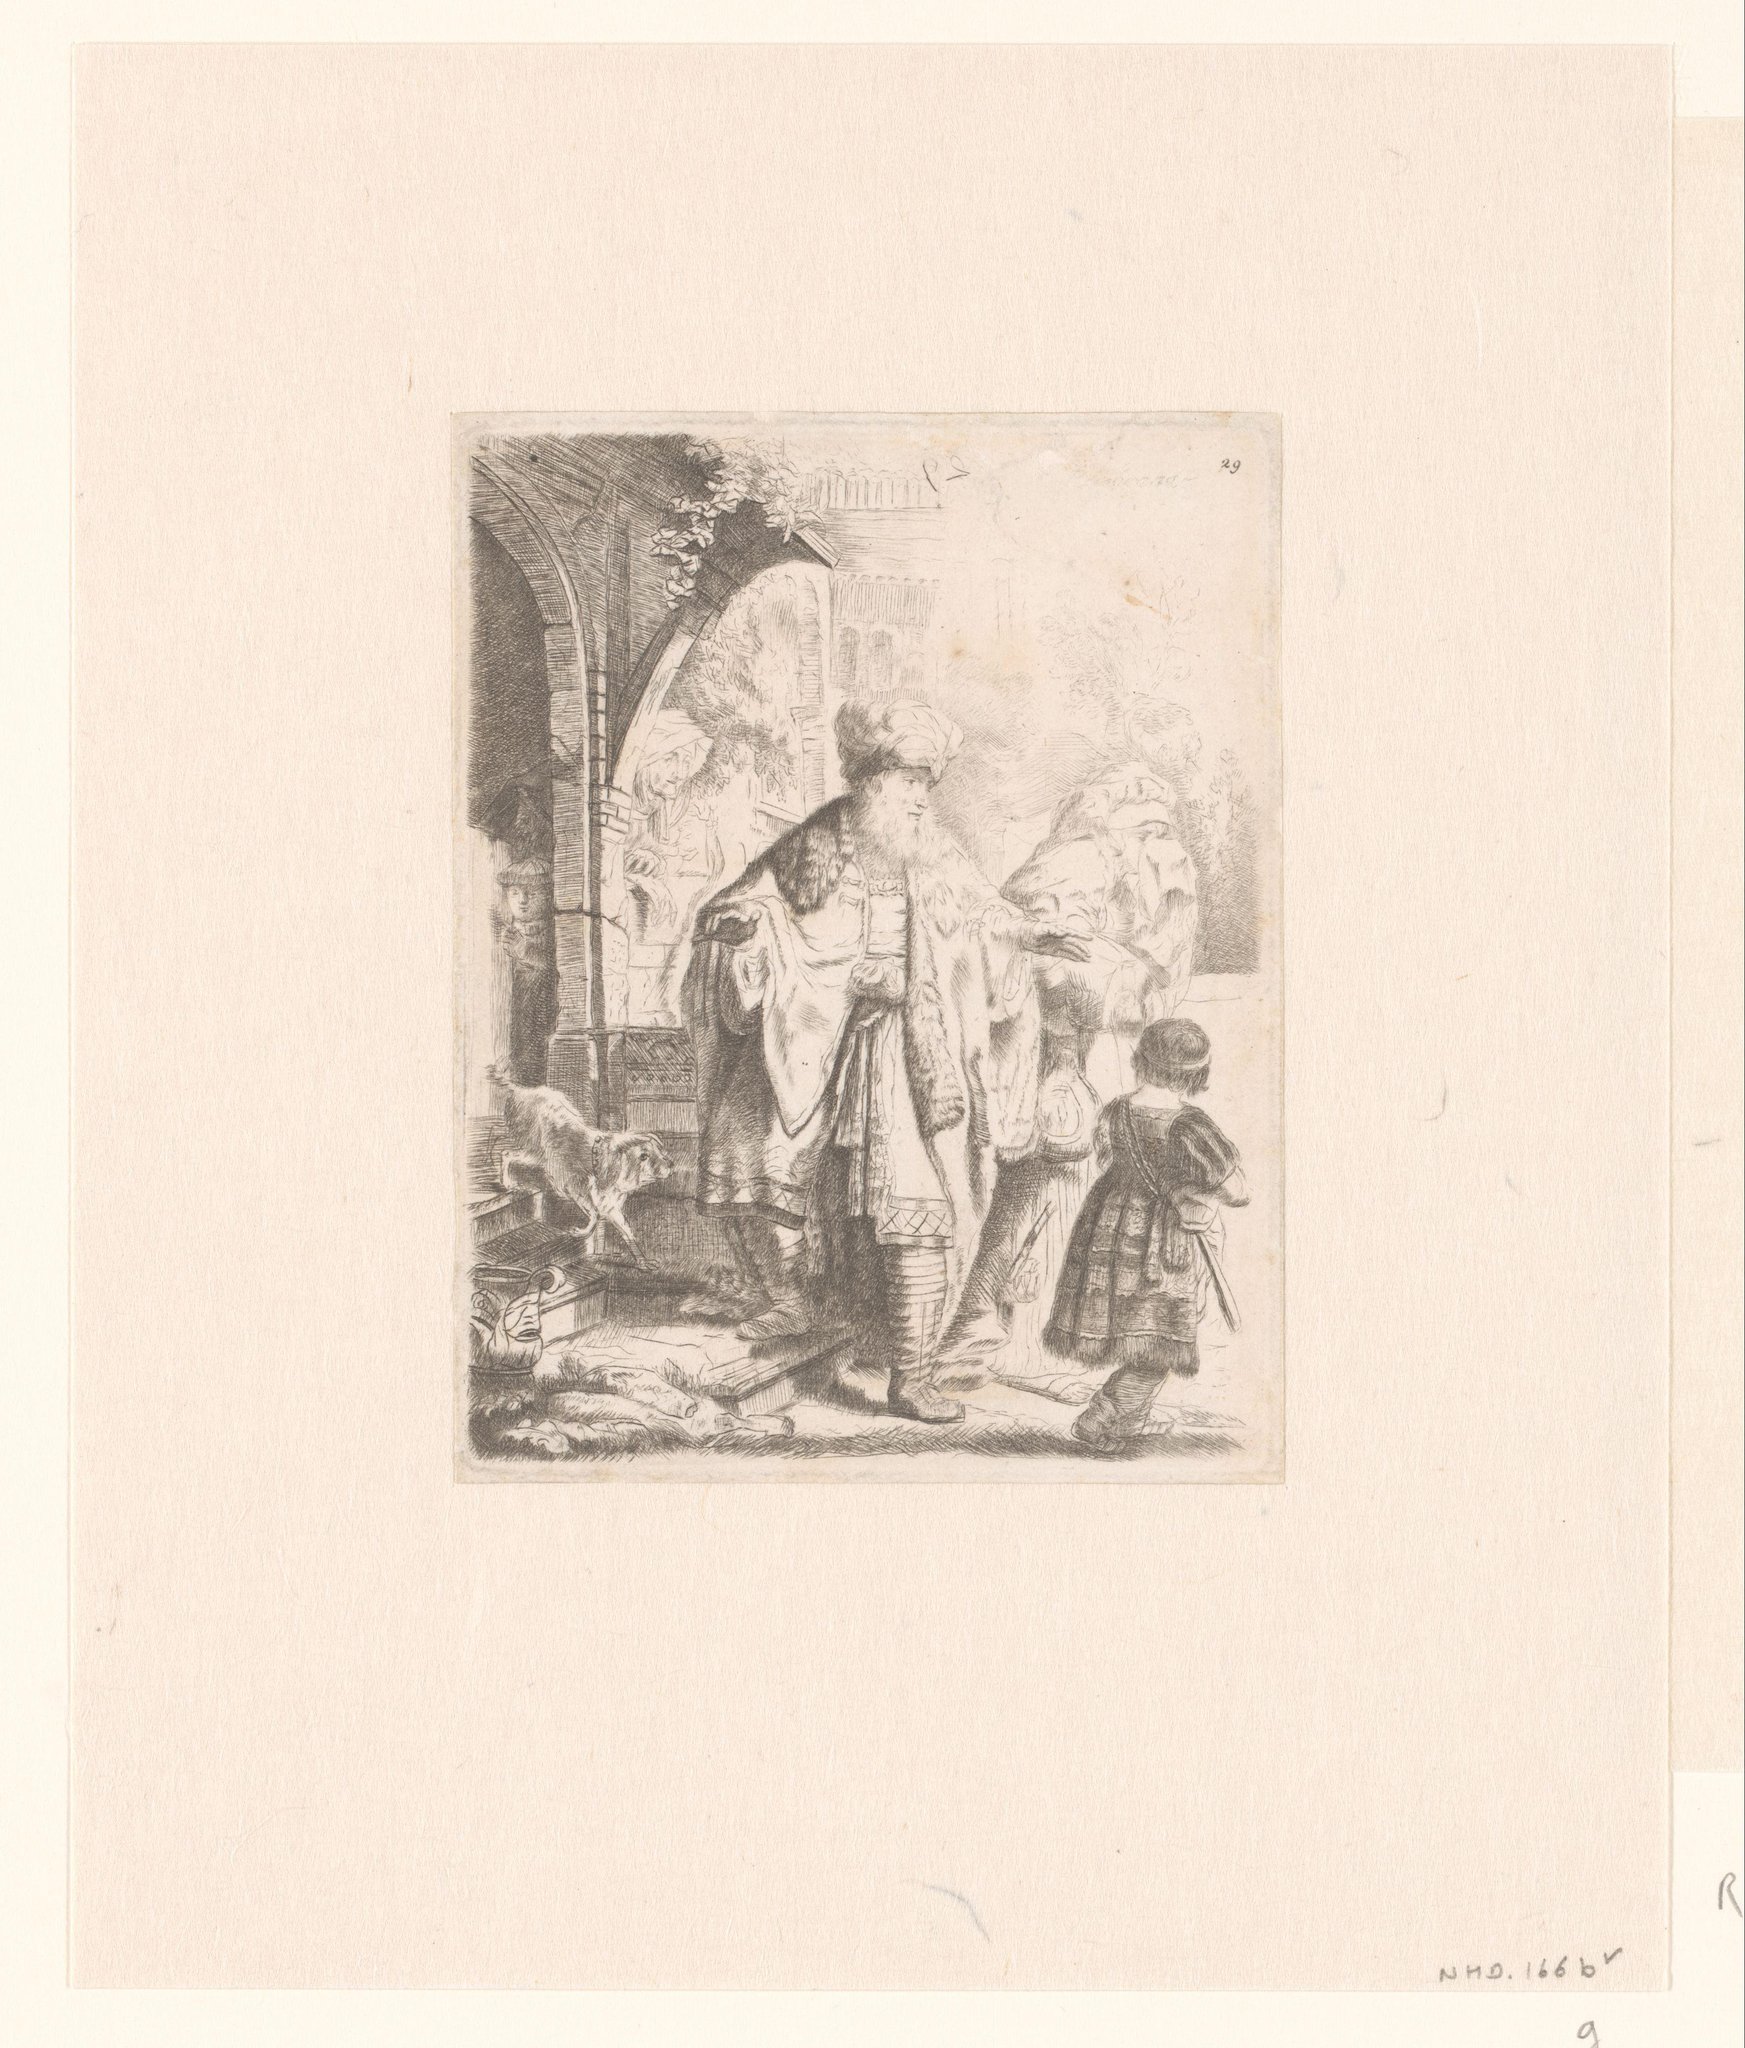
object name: print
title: Abraham casting out Hagar and Ishmael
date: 1710-1766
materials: paper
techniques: etching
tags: the banishment of hagar and ishmael (genesis 21:9-21)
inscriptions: stamp, collector's mark: Lugt 2228, collector's mark: Lugt 2760